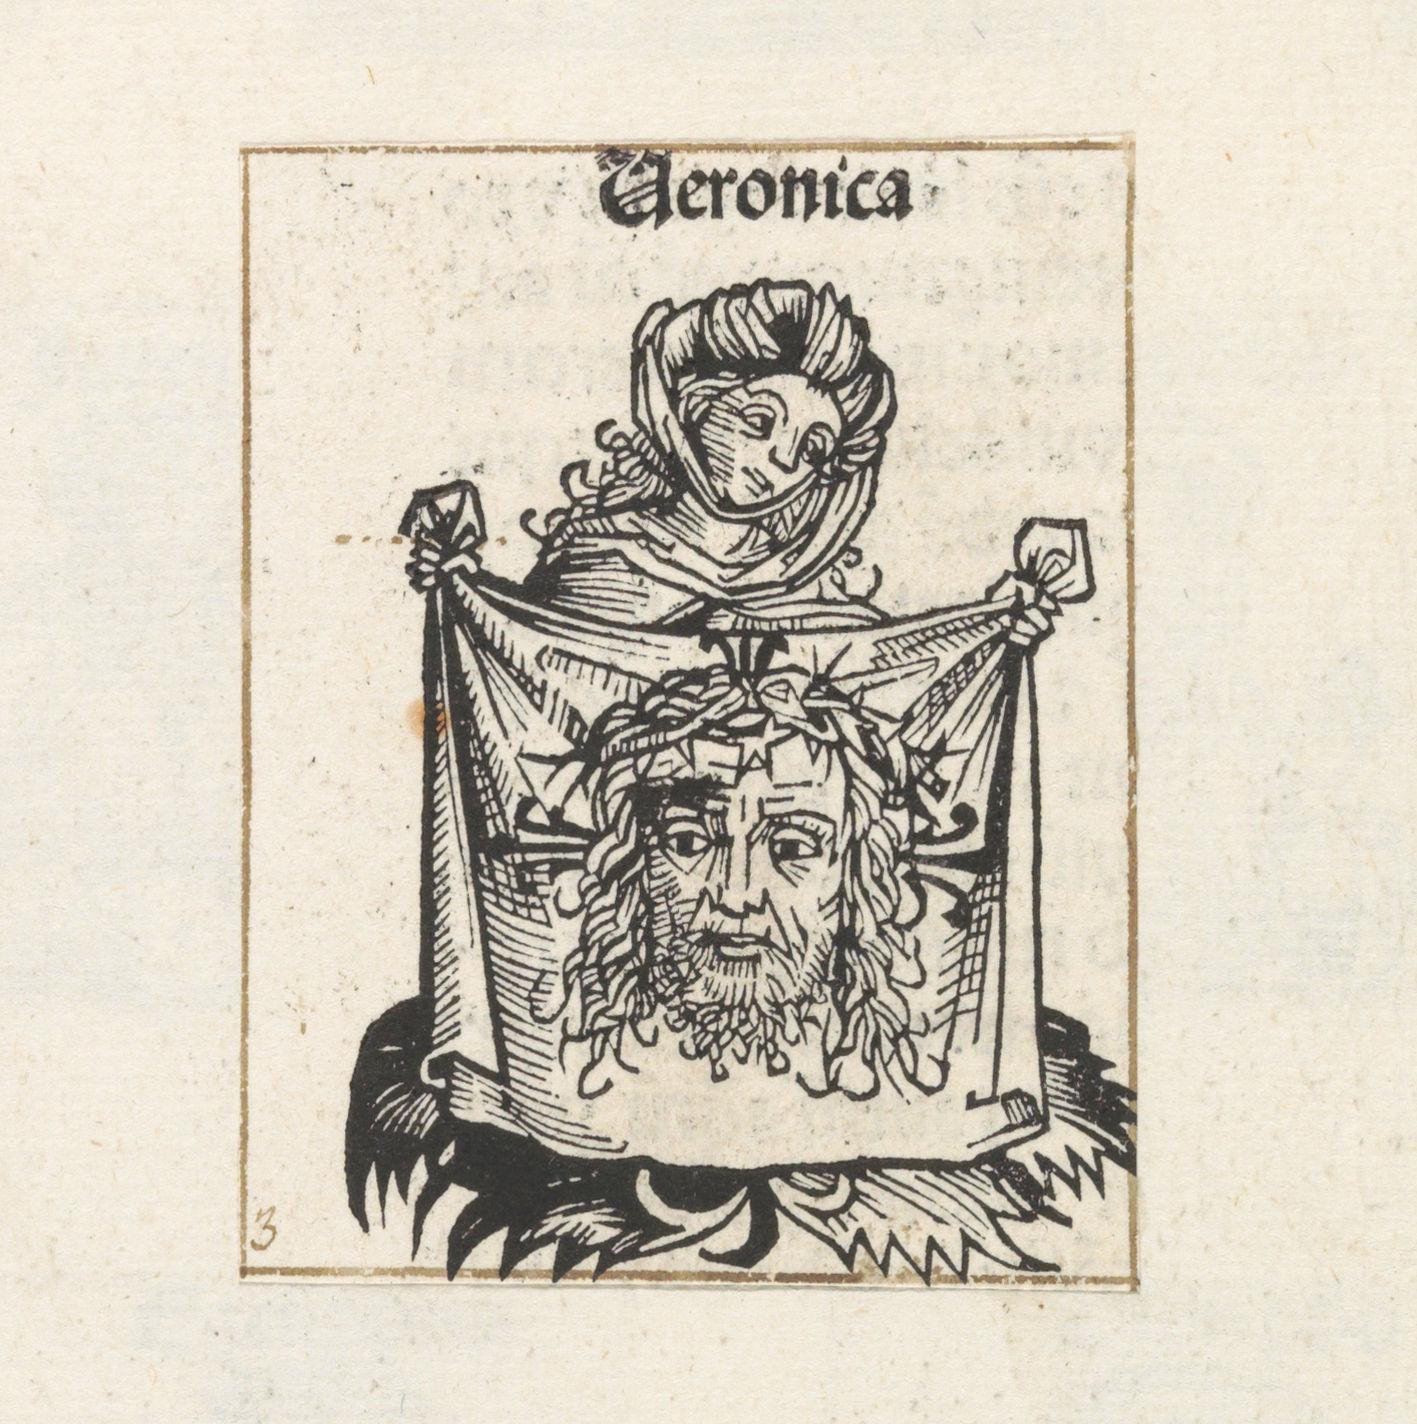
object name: print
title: Heilige Veronica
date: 1493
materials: paper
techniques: letterpress printing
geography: nuremberg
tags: female persons from the new testament (not in biblical context)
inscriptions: inscription: ‘3’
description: De houtsnede wordt herhaaldelijk gebruikt als boekillustratie in de Liber Chronicarum (of Neurenbergkroniek) van Hartmann Schedel, verschenen in het Latijn en Duits in 1493. Zie de Latijnse uitgave, folio 97r.